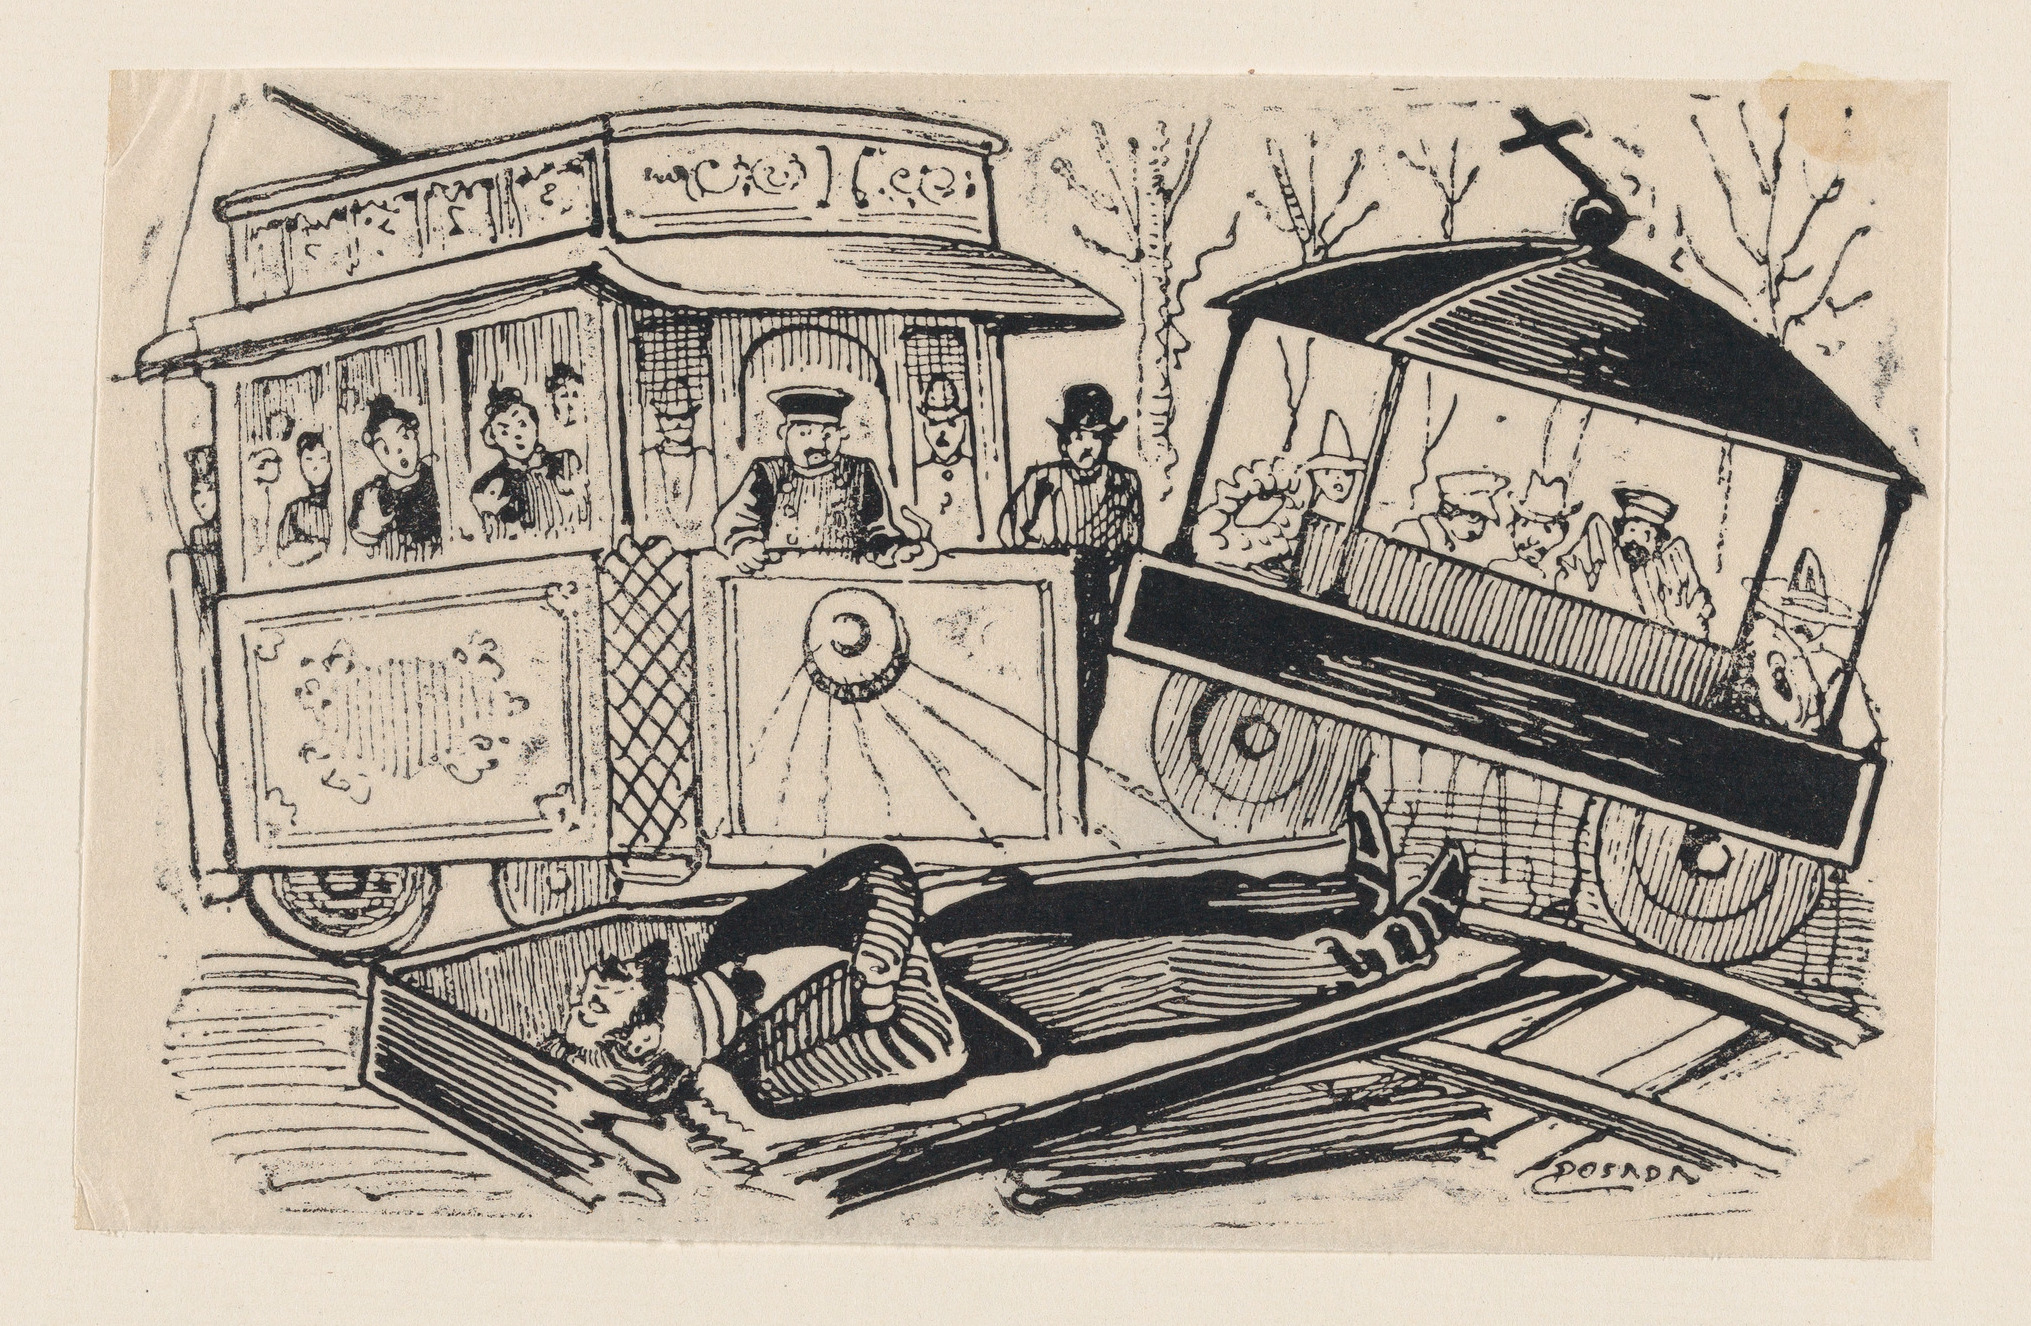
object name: print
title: Collision between a trolley and a hearse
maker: josé guadalupe posada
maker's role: artist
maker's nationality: mexican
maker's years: 1852-1913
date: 1880-1910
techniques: lithography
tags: corpses,men,women,streetcars